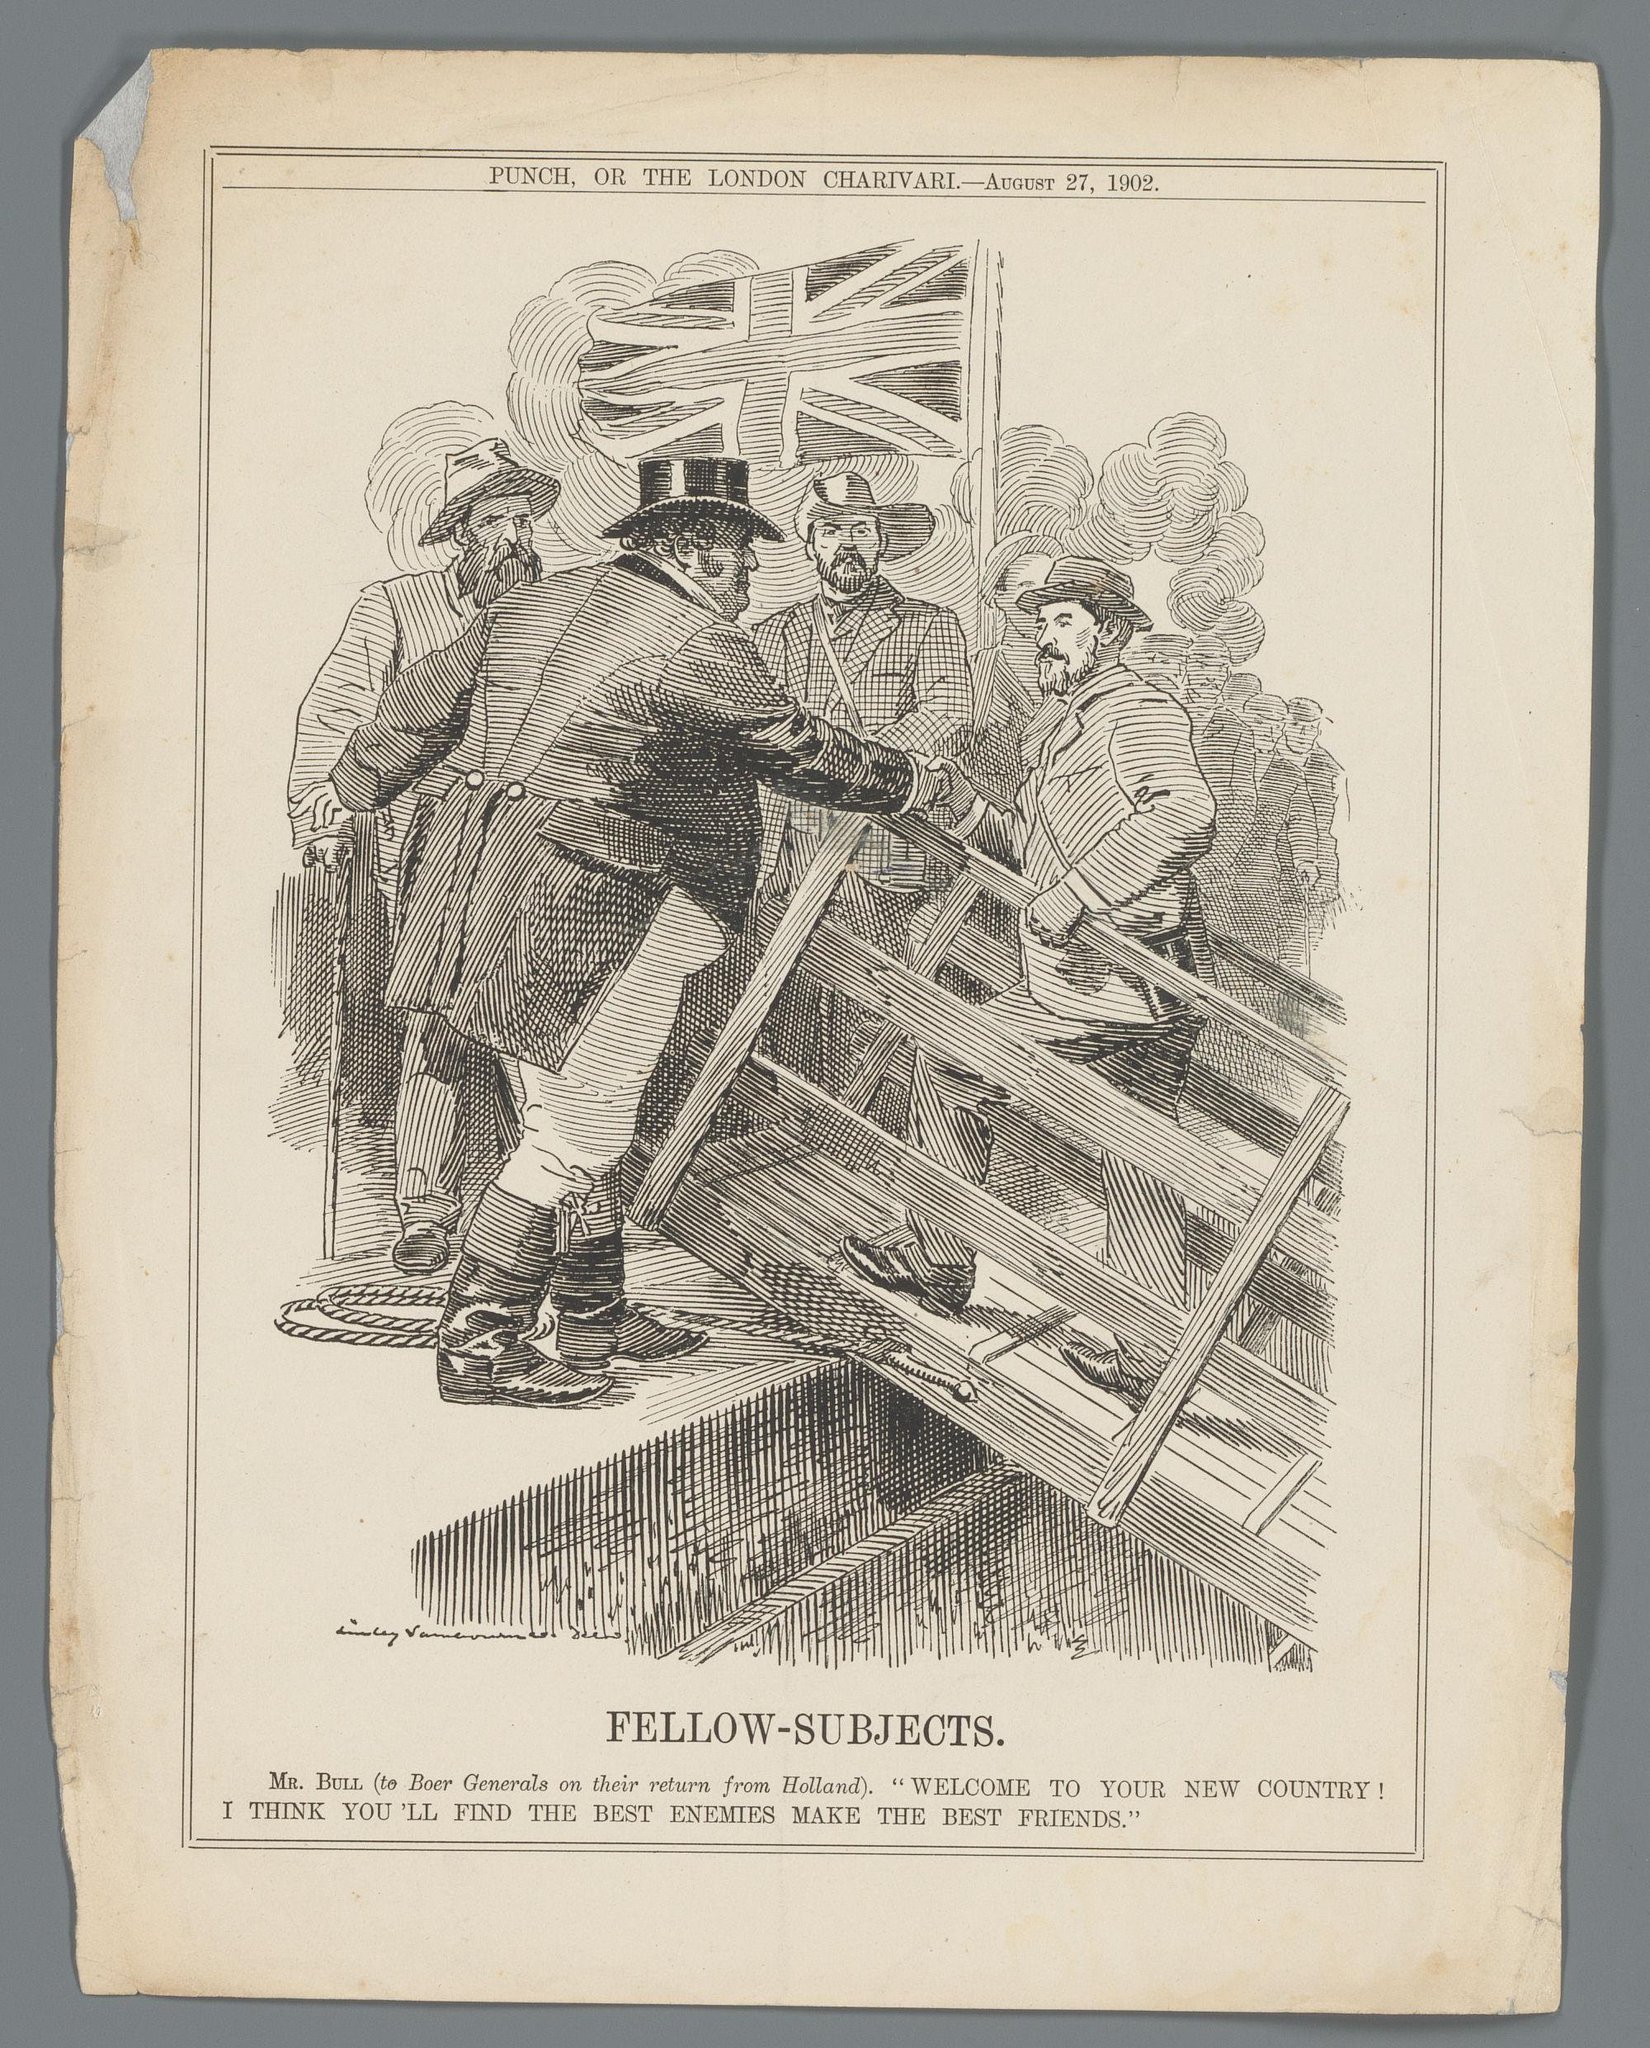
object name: print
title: Fellow-subjects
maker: edward linley sambourne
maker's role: draughtsman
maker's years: 1844-1910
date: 1902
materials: paper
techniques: line block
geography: england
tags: personifications of countries, nations, states, districts, etc., political caricatures and satires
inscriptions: date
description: John Bull verwelkomt de Boerengeneraals bij hun terugkeer uit Nederland in Zuid-Afrika. Spotprent uit het Engelse satirische tijdschrift Punch, 27 augustus 1902.